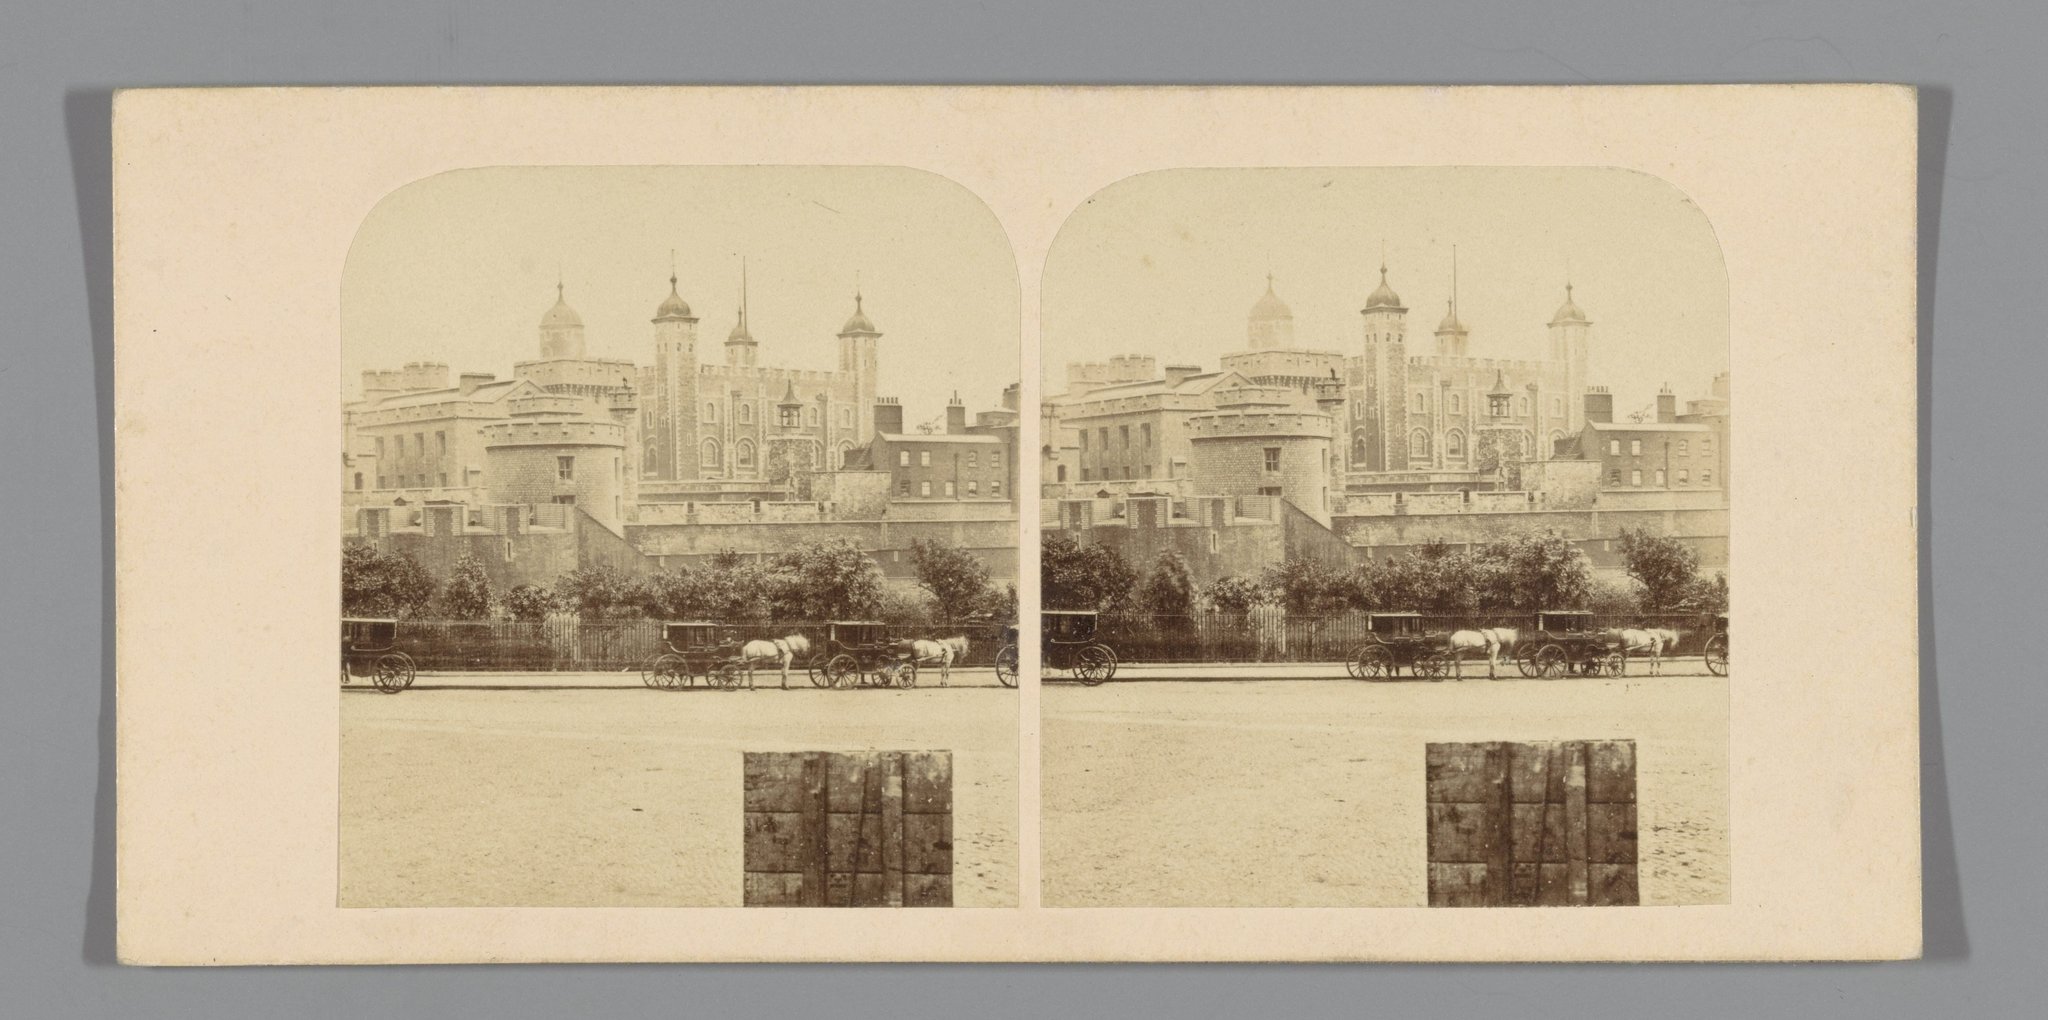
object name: stereograph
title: Gezicht op de Tower of London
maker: Anonymous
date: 1850-1880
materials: cardboard, photographic support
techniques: albumen print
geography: london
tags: palace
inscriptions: number: ‘10.’